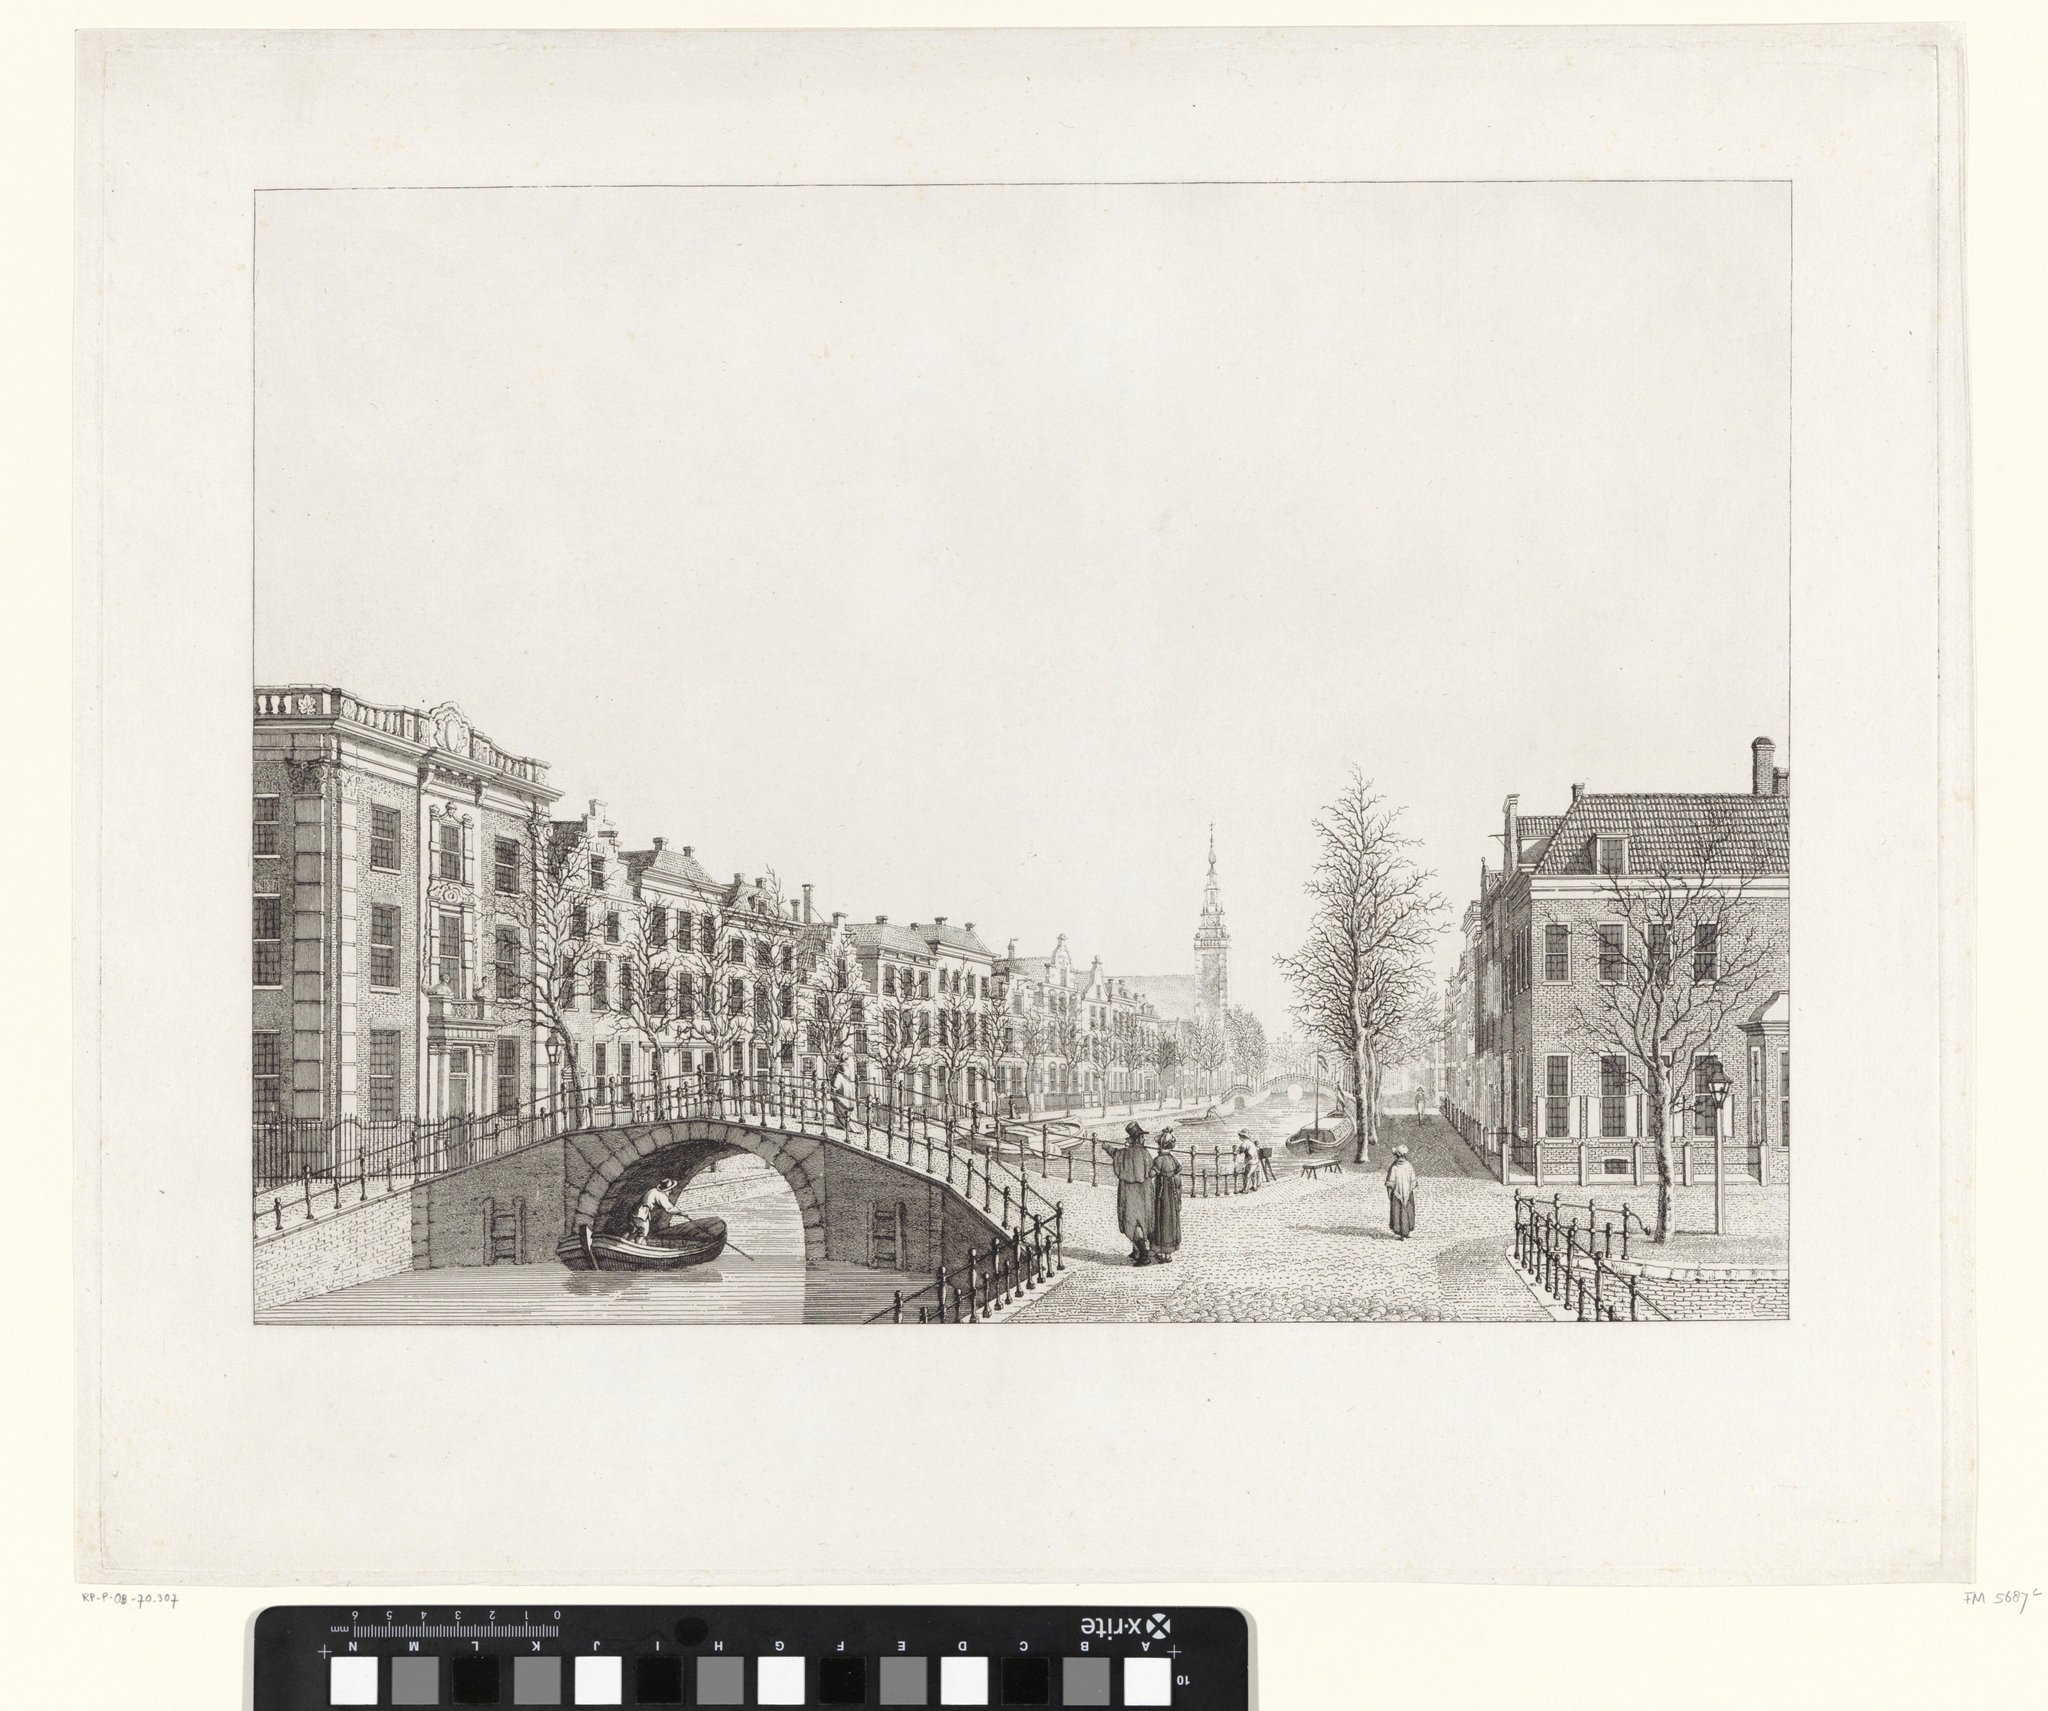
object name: print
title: Vier Kunstplaten voorstellende het Rapenburg binnen de stad Leyden, zoodanig als het (ter wederzijde) zich vertoond heeft, even vóór de noodlottige gebeurtenis, op den 12den Januarij 1807. als mede de wederzijdsche ruïnes door die ijselijke uitbarsting veroorzaakt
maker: reinier vinkeles (i)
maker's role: draughtsman, print maker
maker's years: 1741-1816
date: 1807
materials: paper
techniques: etching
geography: amsterdam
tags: city-view in general; 'veduta'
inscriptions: collector's mark: Lugt 2228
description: Gezicht op het Steenschuur, een gracht in het verlengde van het Rapenburg, te Leiden, in welstand vóór de buskruitramp van 12 januari 1807. Links op de voorgrond de Nieuwsteegbrug met daarachter het Steenschuur. Links op de hoek van het Steenschuur het huis van schepen J.W. van Noort. Op de achtergrond de Saaihal (de latere Sint-Lodewijkskerk).